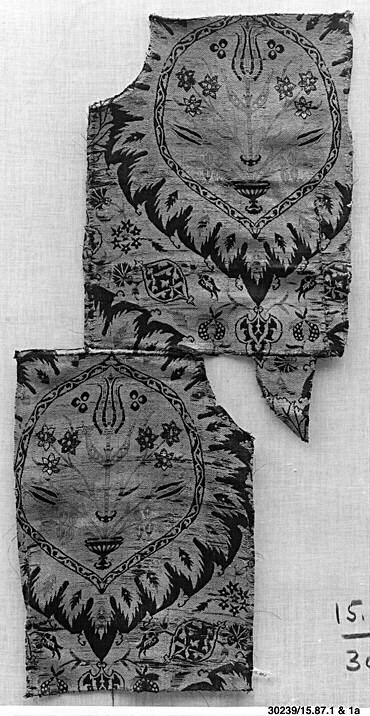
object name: textile fragment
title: Brocade Fragment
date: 1501-1600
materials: metal thread, silk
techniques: brocade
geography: turkey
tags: flowers